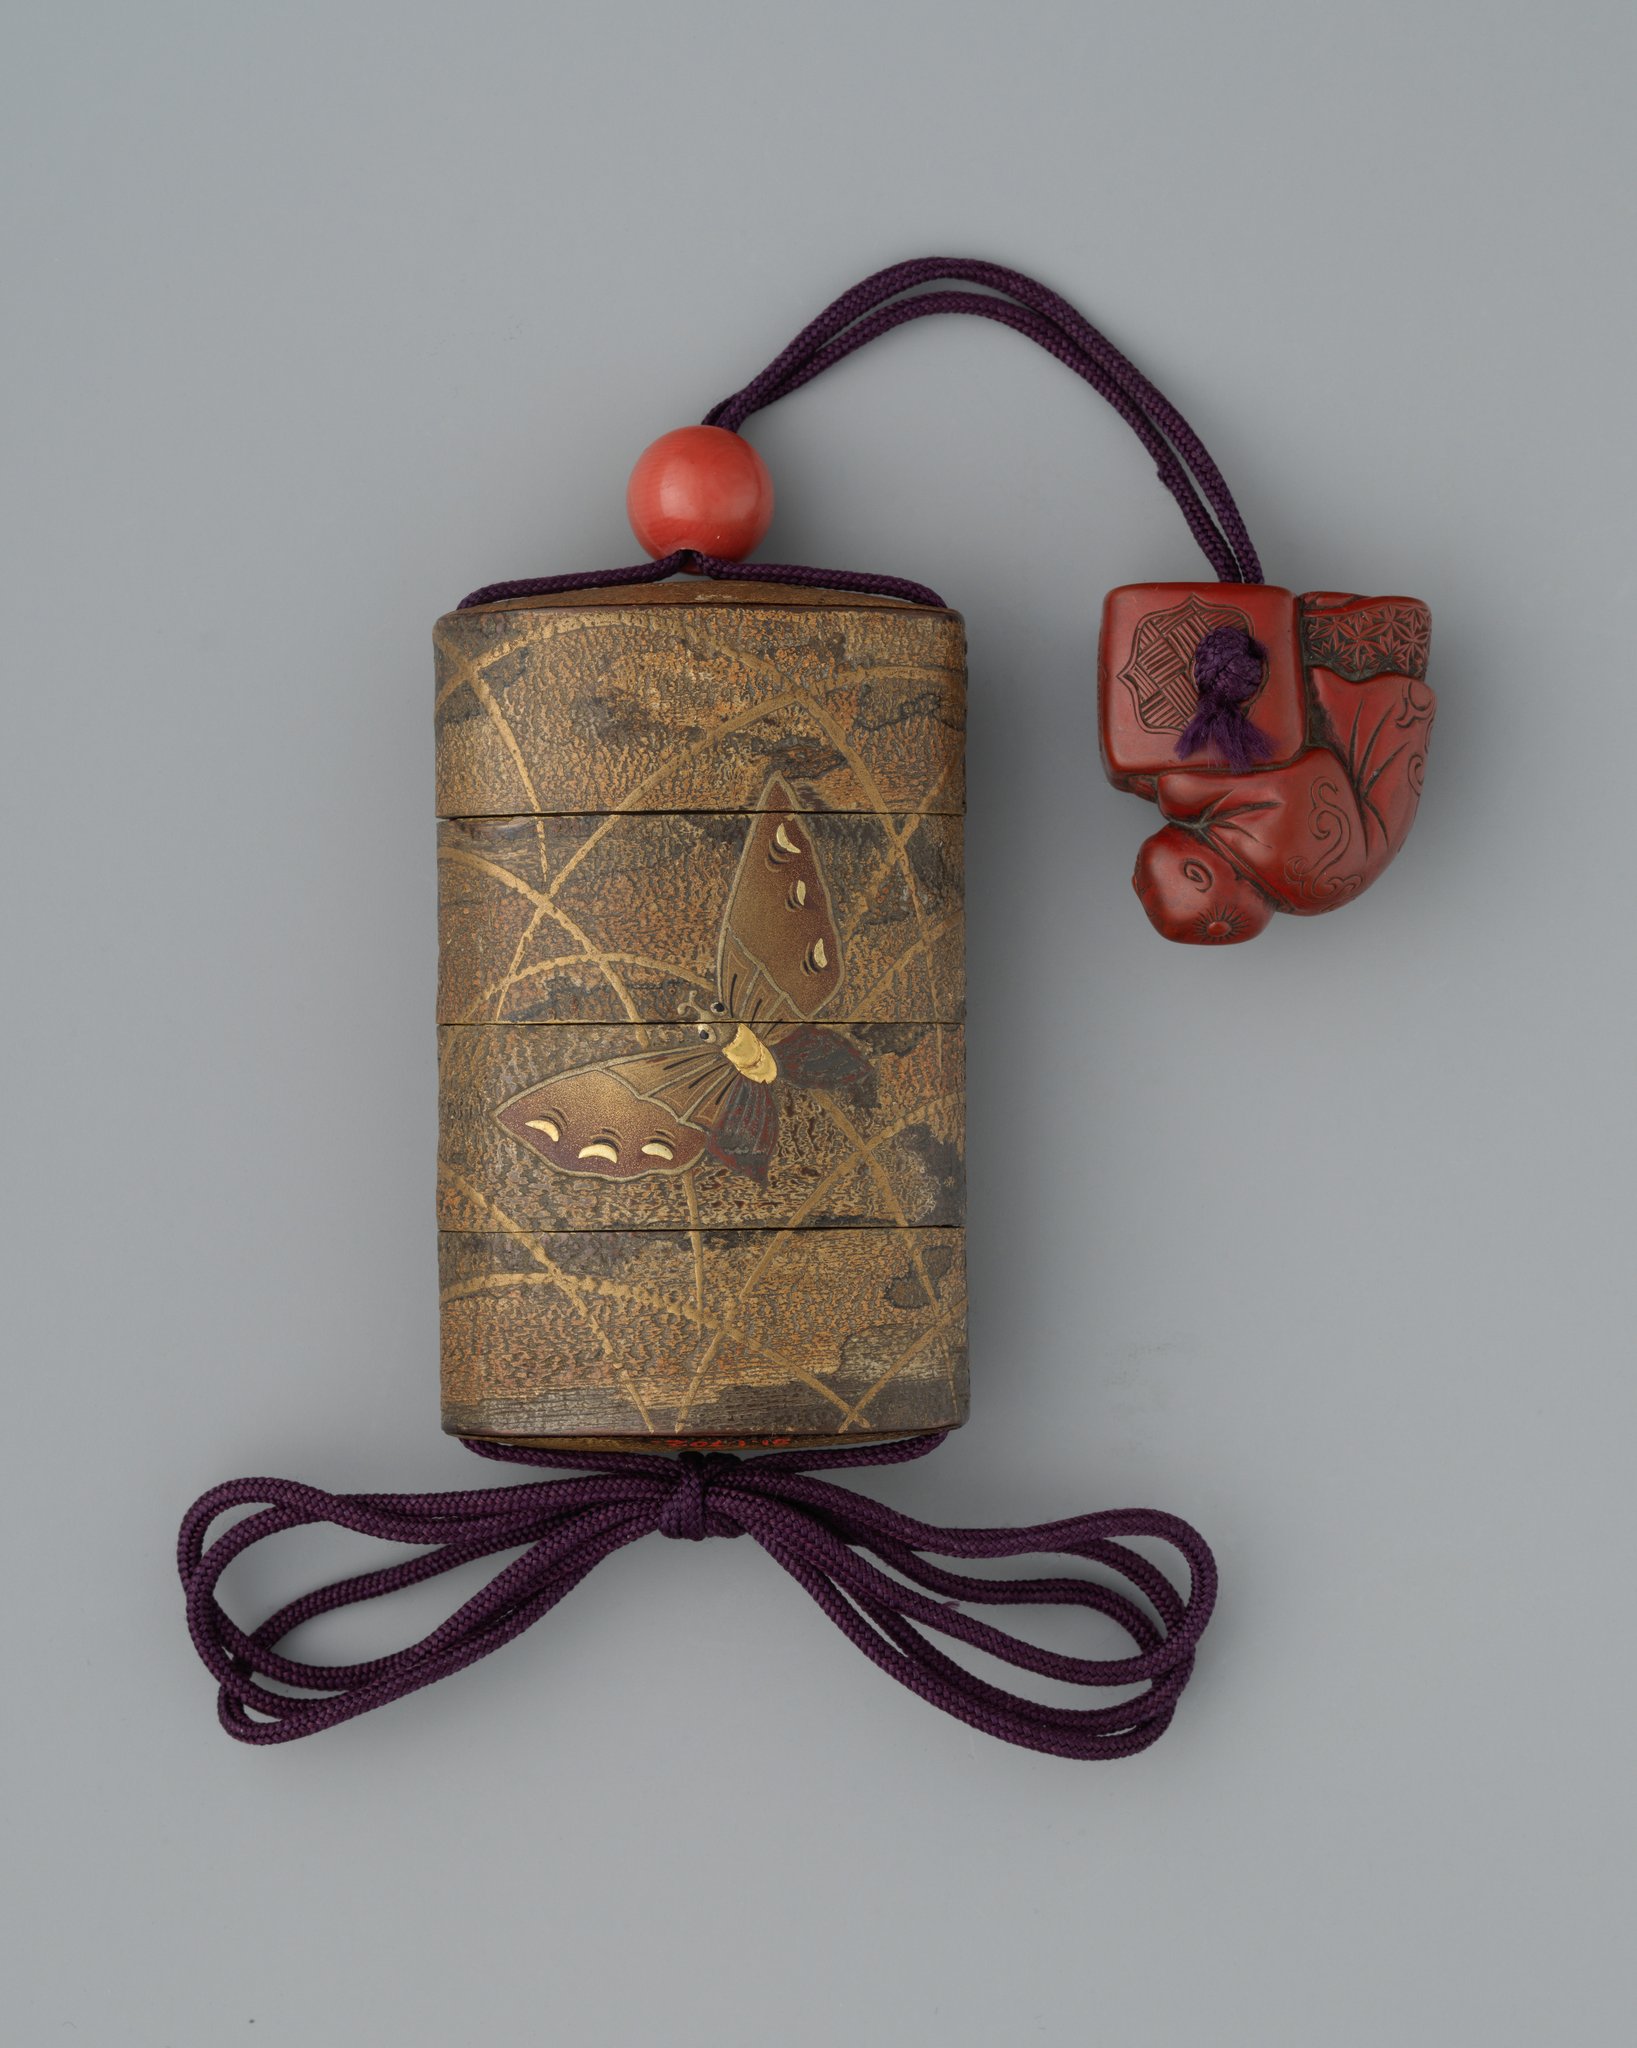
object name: inrō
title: Inrō with Butterflies and Pampas Grass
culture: japanese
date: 1834-1866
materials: foil, gold, lacquer, silver, stone, wood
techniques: carving, hiramakie, lacquer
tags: butterflies